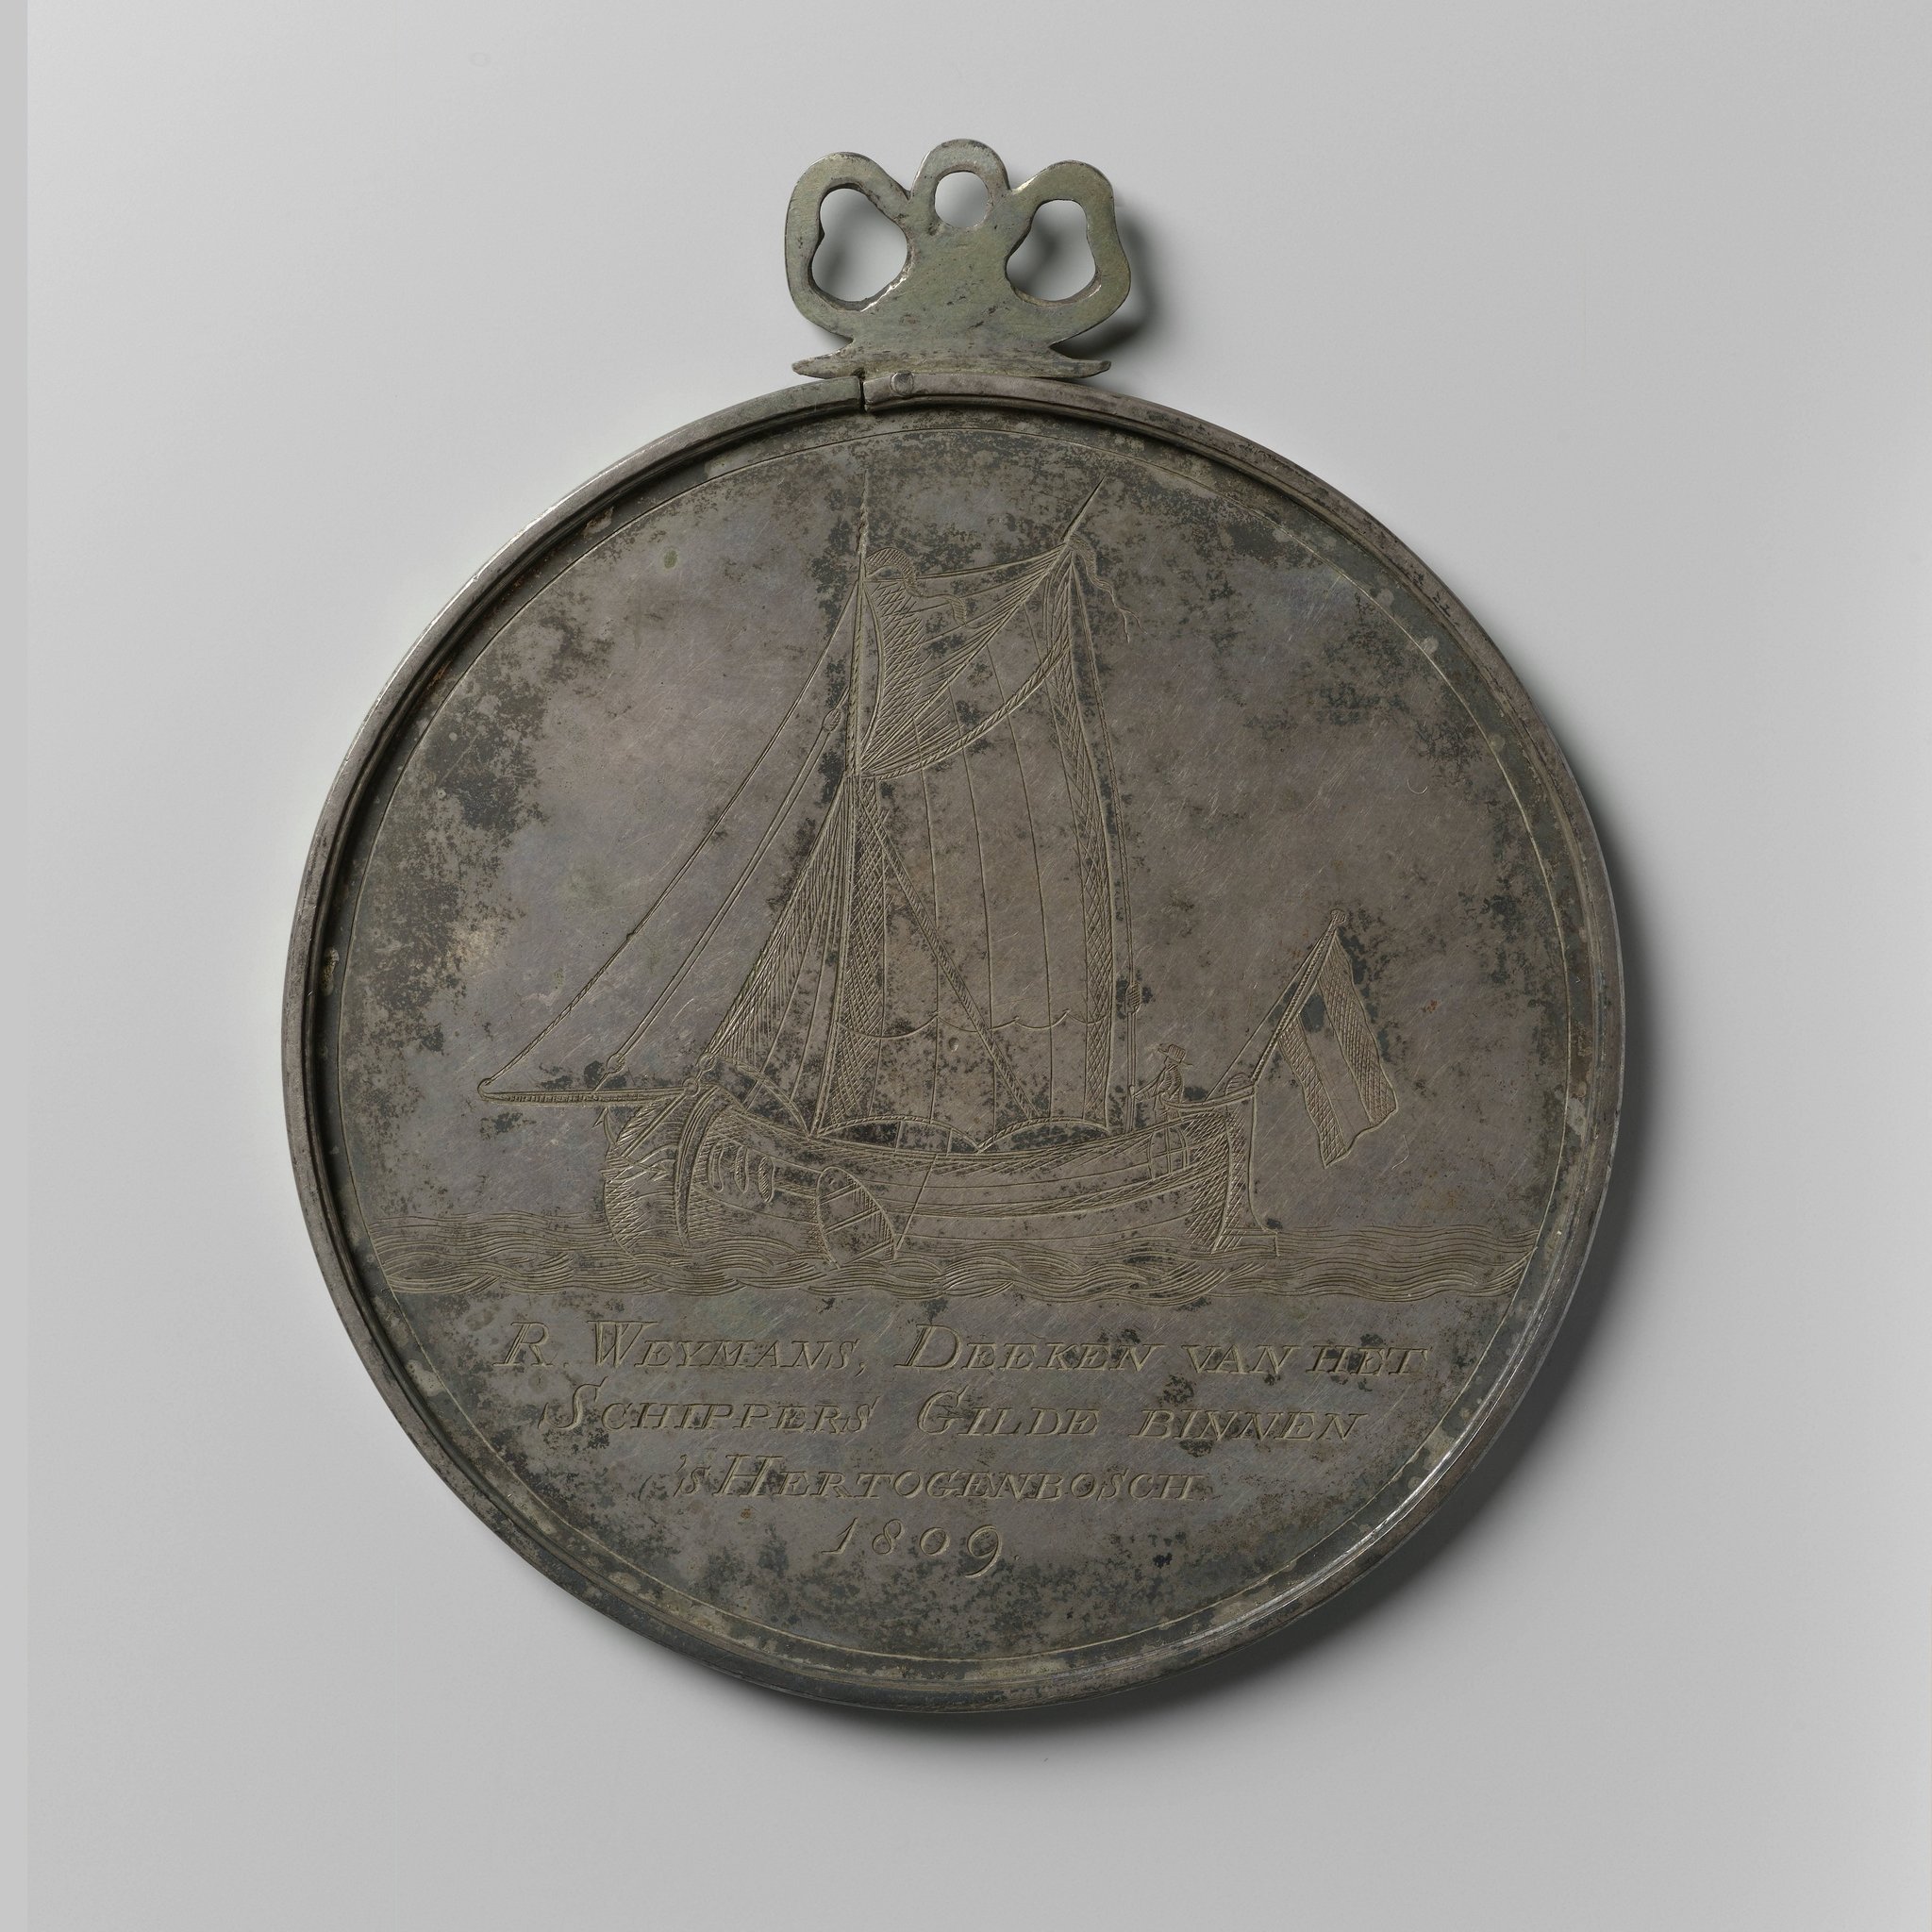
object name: medal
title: Schippersgilde te 's-Hertogenbosch, penning van deken R. Weymans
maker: Anonymous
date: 1809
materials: silver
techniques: engraving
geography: den bosch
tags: den bosch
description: Zilveren penning aan een opengewerkte metalen strik. Voorzijde: gekroond wapenschild op ruitvloer, geflankeerd door twee halfnaakte mannen met knots over schouder; daaronder bladerguirlande. Keerzijde: schip boven opschrift